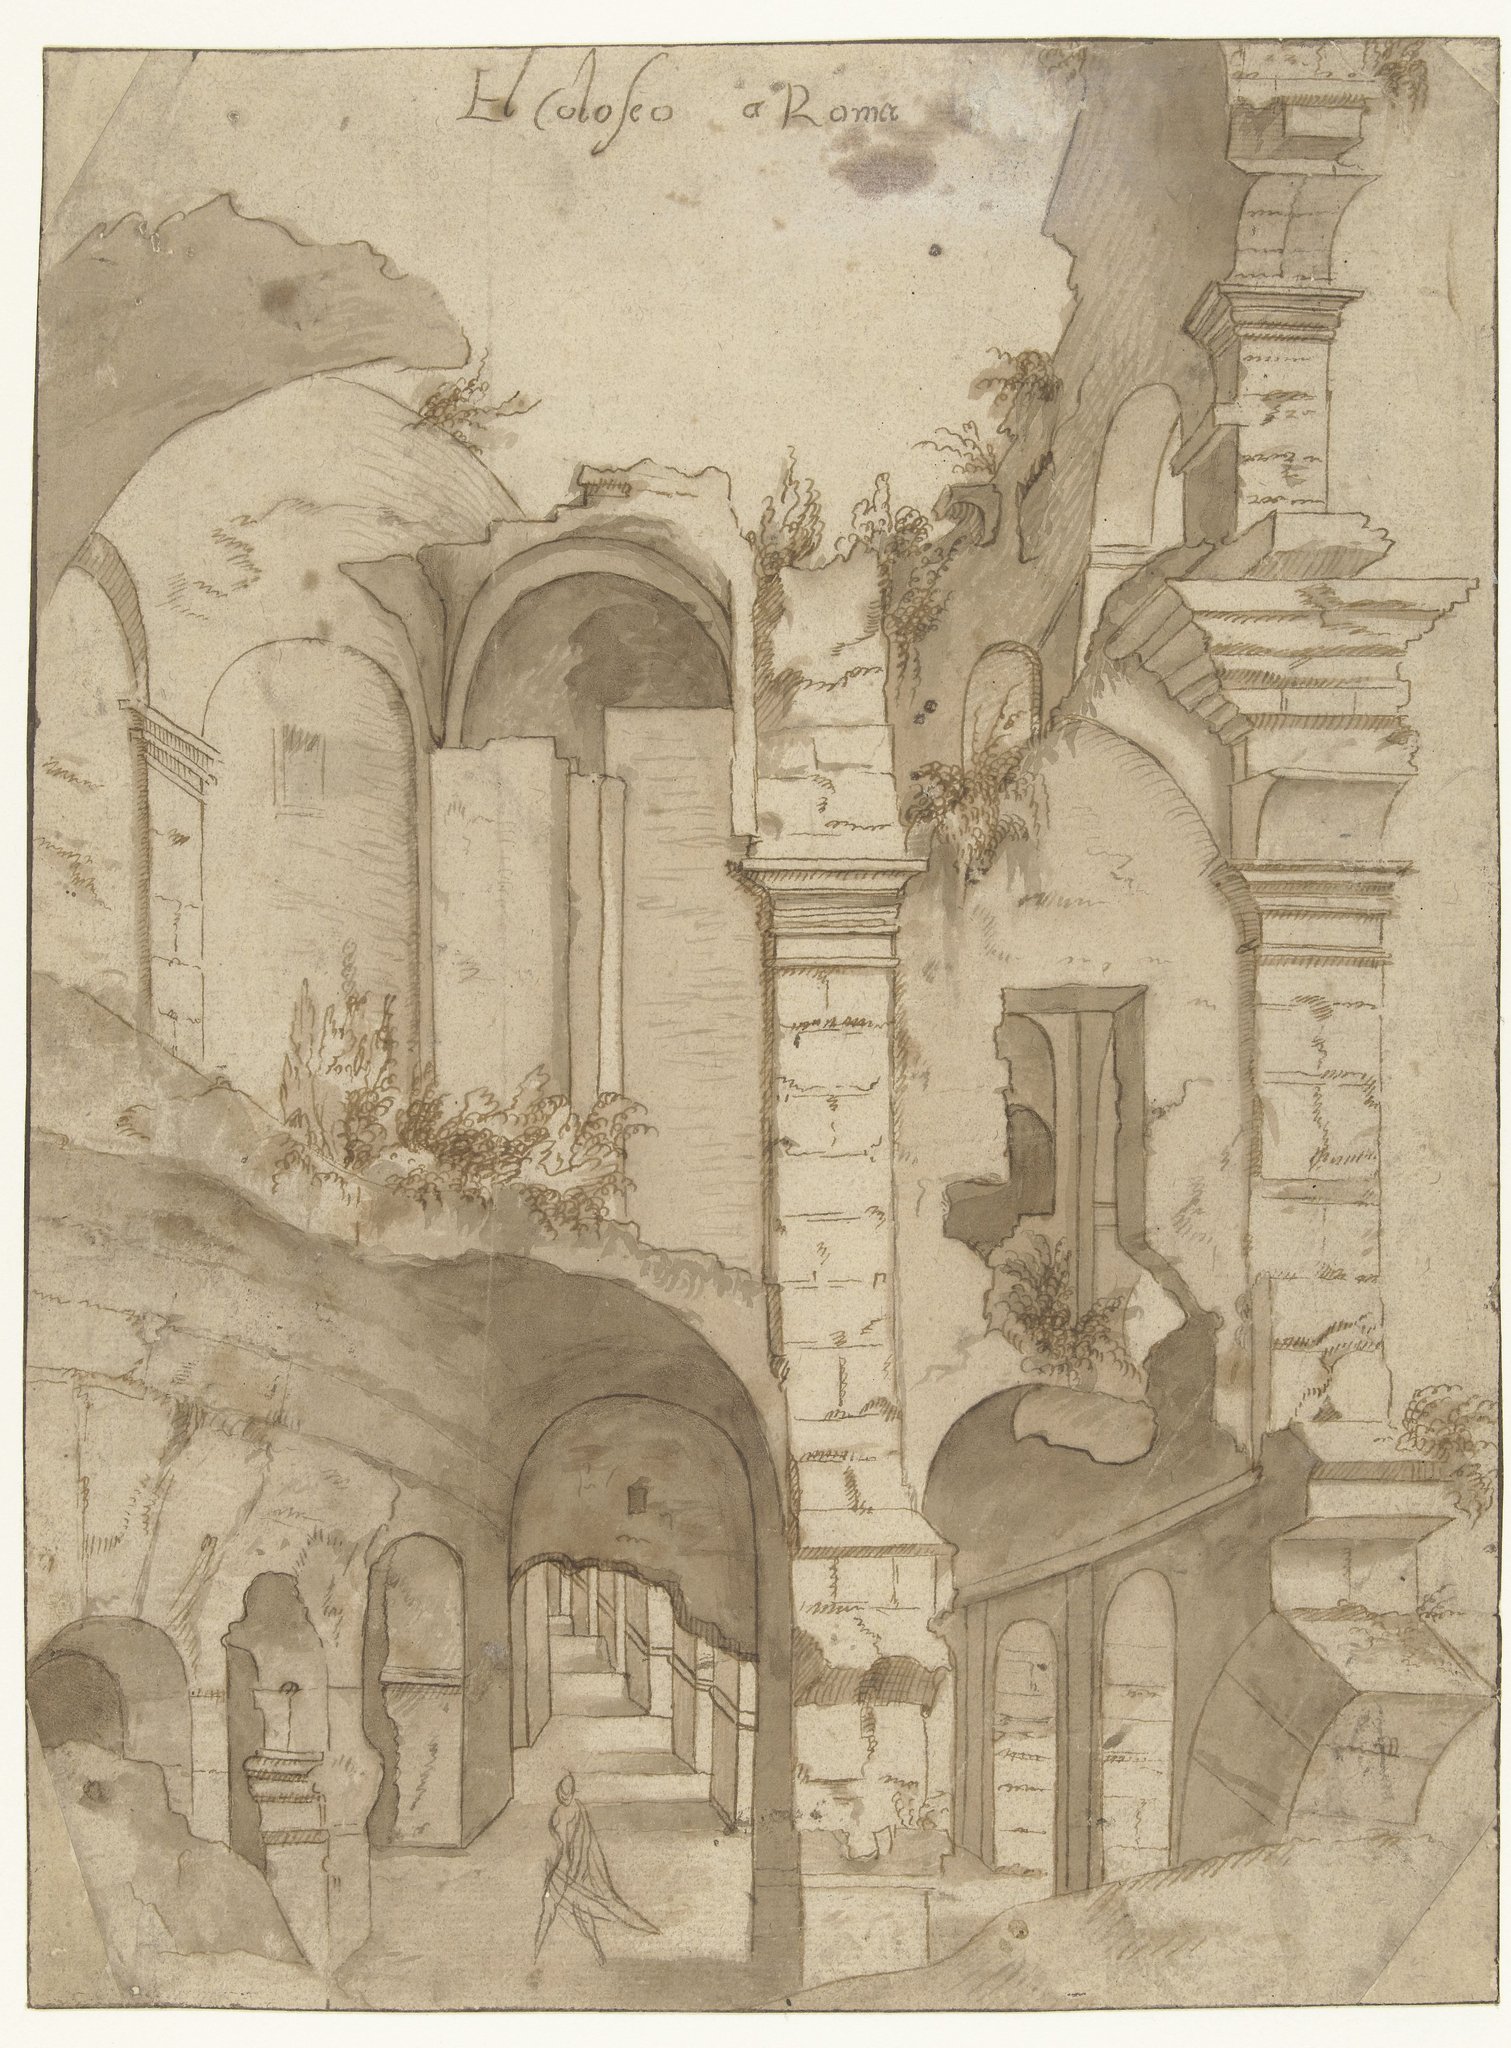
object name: drawing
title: Gezicht op Colosseum te Rome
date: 1536-1586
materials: ink, paper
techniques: brush, pen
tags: colosseum